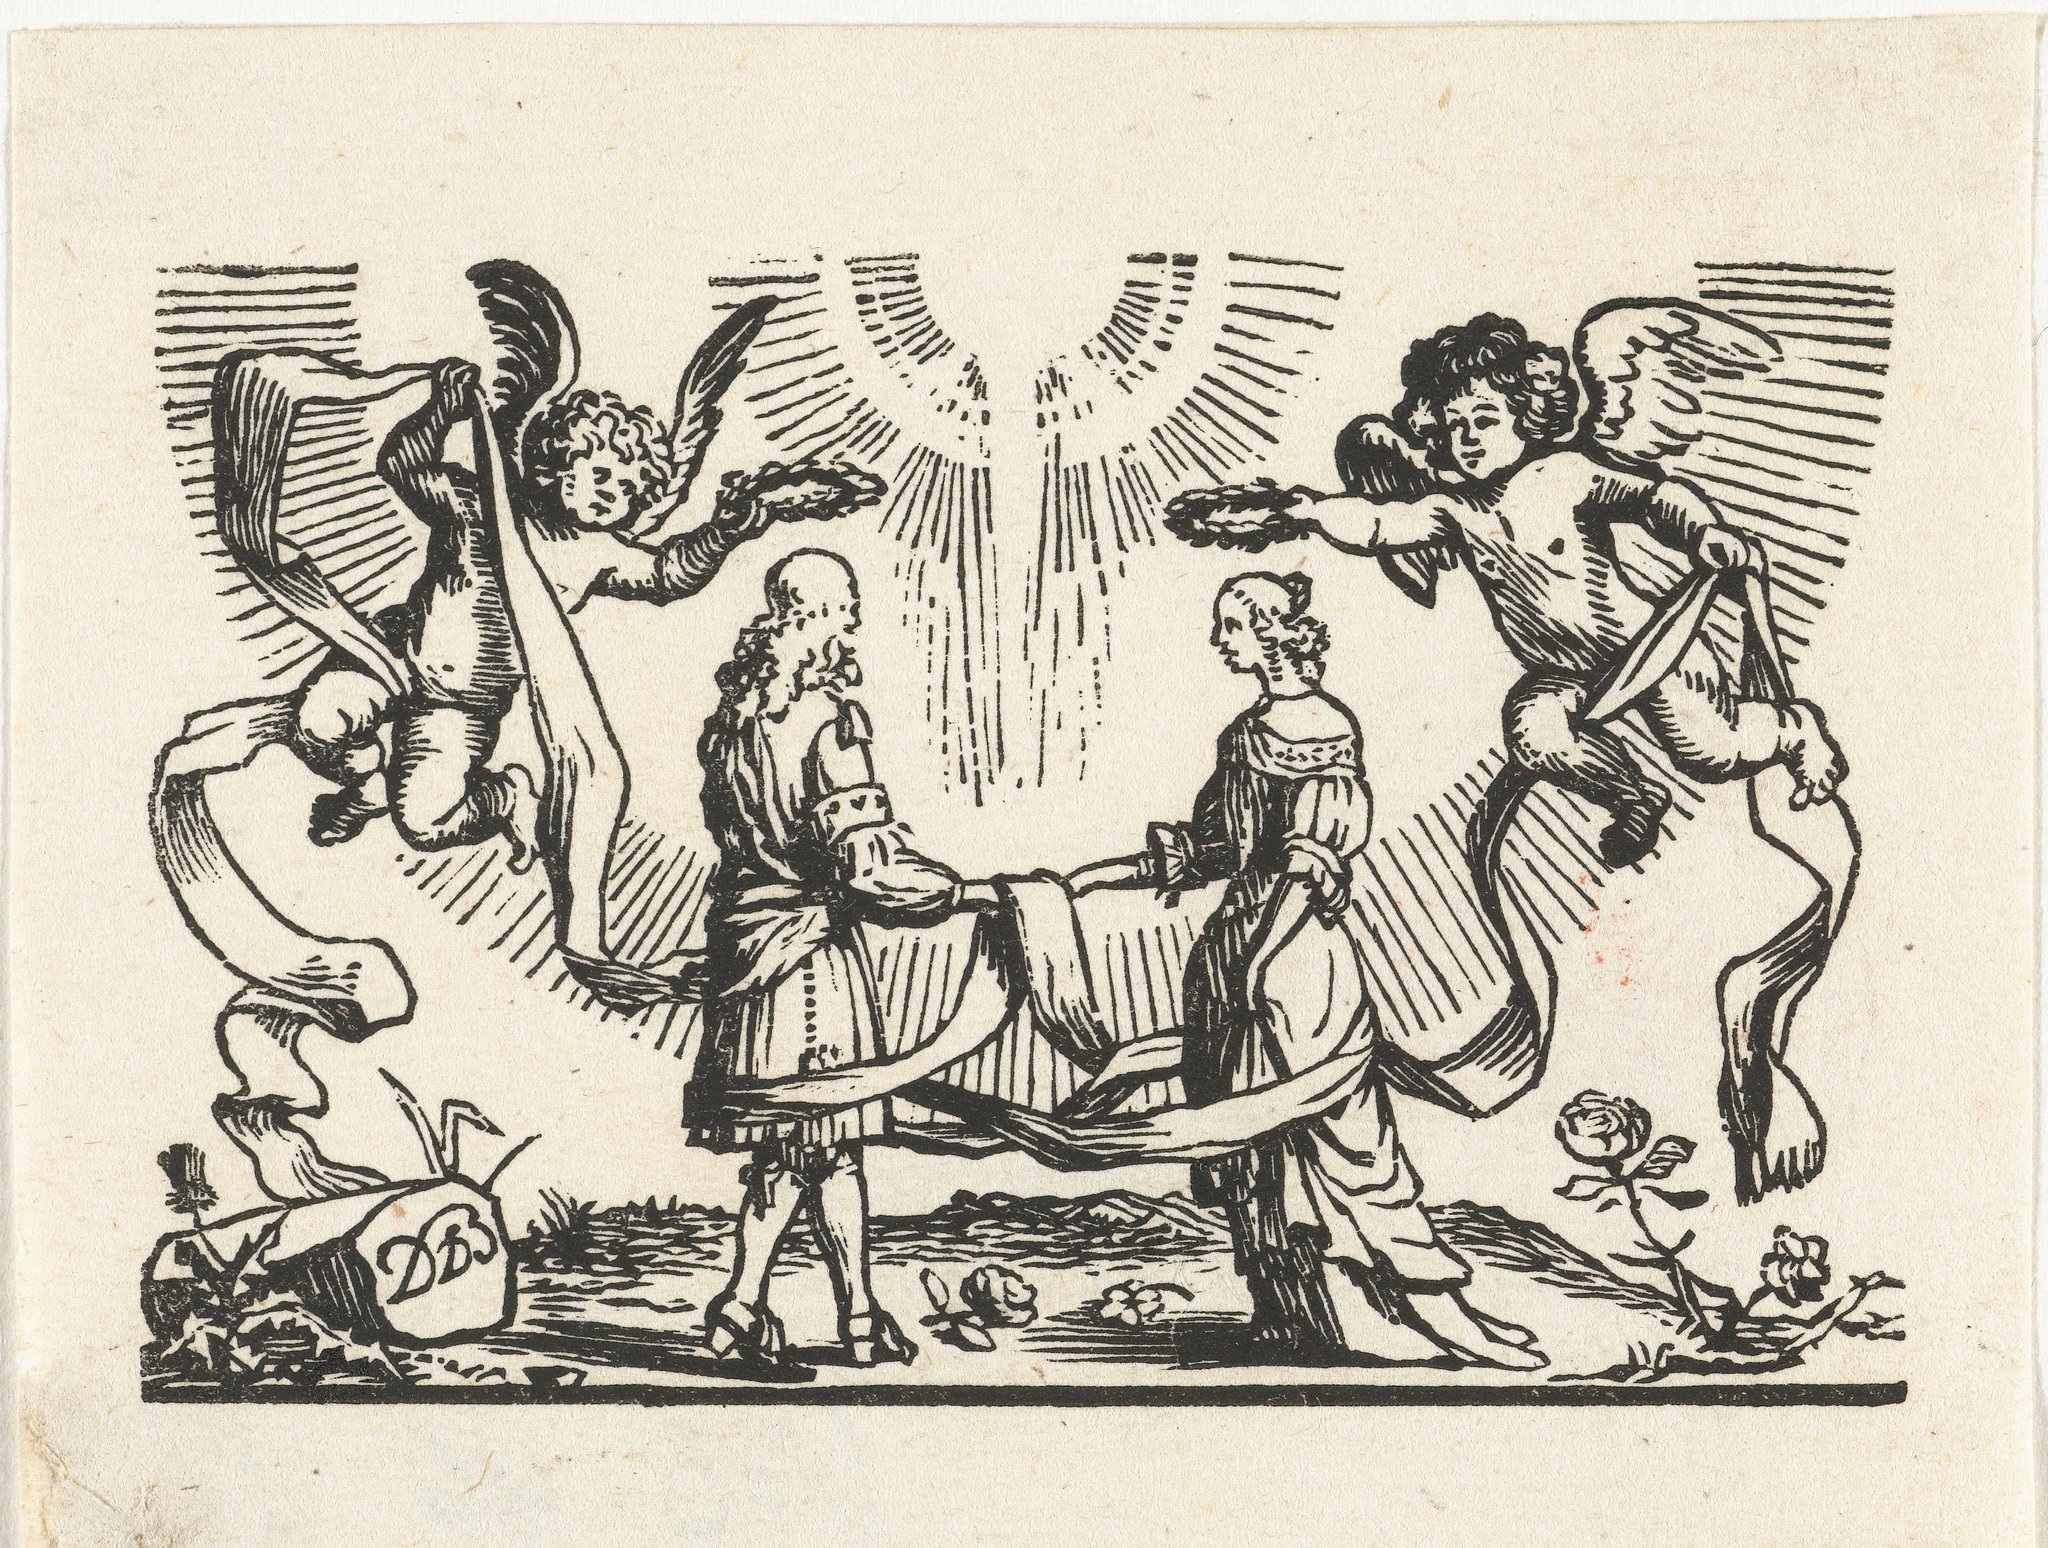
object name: print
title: Allegorie met een jonge vrouw en een man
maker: dirck de bray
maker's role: draughtsman, painter, print maker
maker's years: 1625-1694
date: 1635-1694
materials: paper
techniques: woodcut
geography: netherlands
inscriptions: collector's mark: Lugt 240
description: Een jonge vrouw en een man houden elkaars rechterhand vast. Zij worden gekroond door twee engelen en met elkaar verbonden door een lang lint.